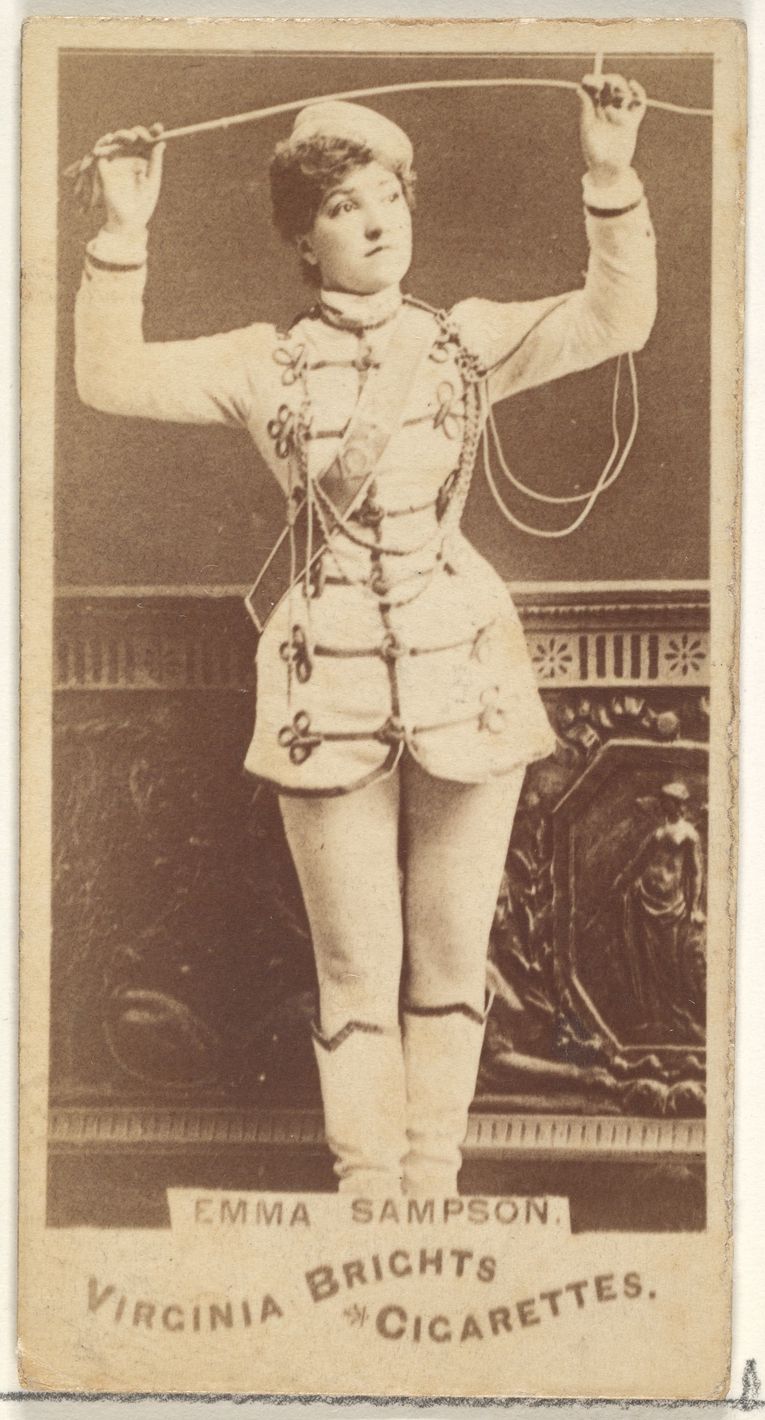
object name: photograph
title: Emma Sampson, from the Actors and Actresses series (N45, Type 1) for Virginia Brights Cigarettes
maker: allen & ginter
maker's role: publisher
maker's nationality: american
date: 1888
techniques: albumen silver print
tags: portraits,women,actresses